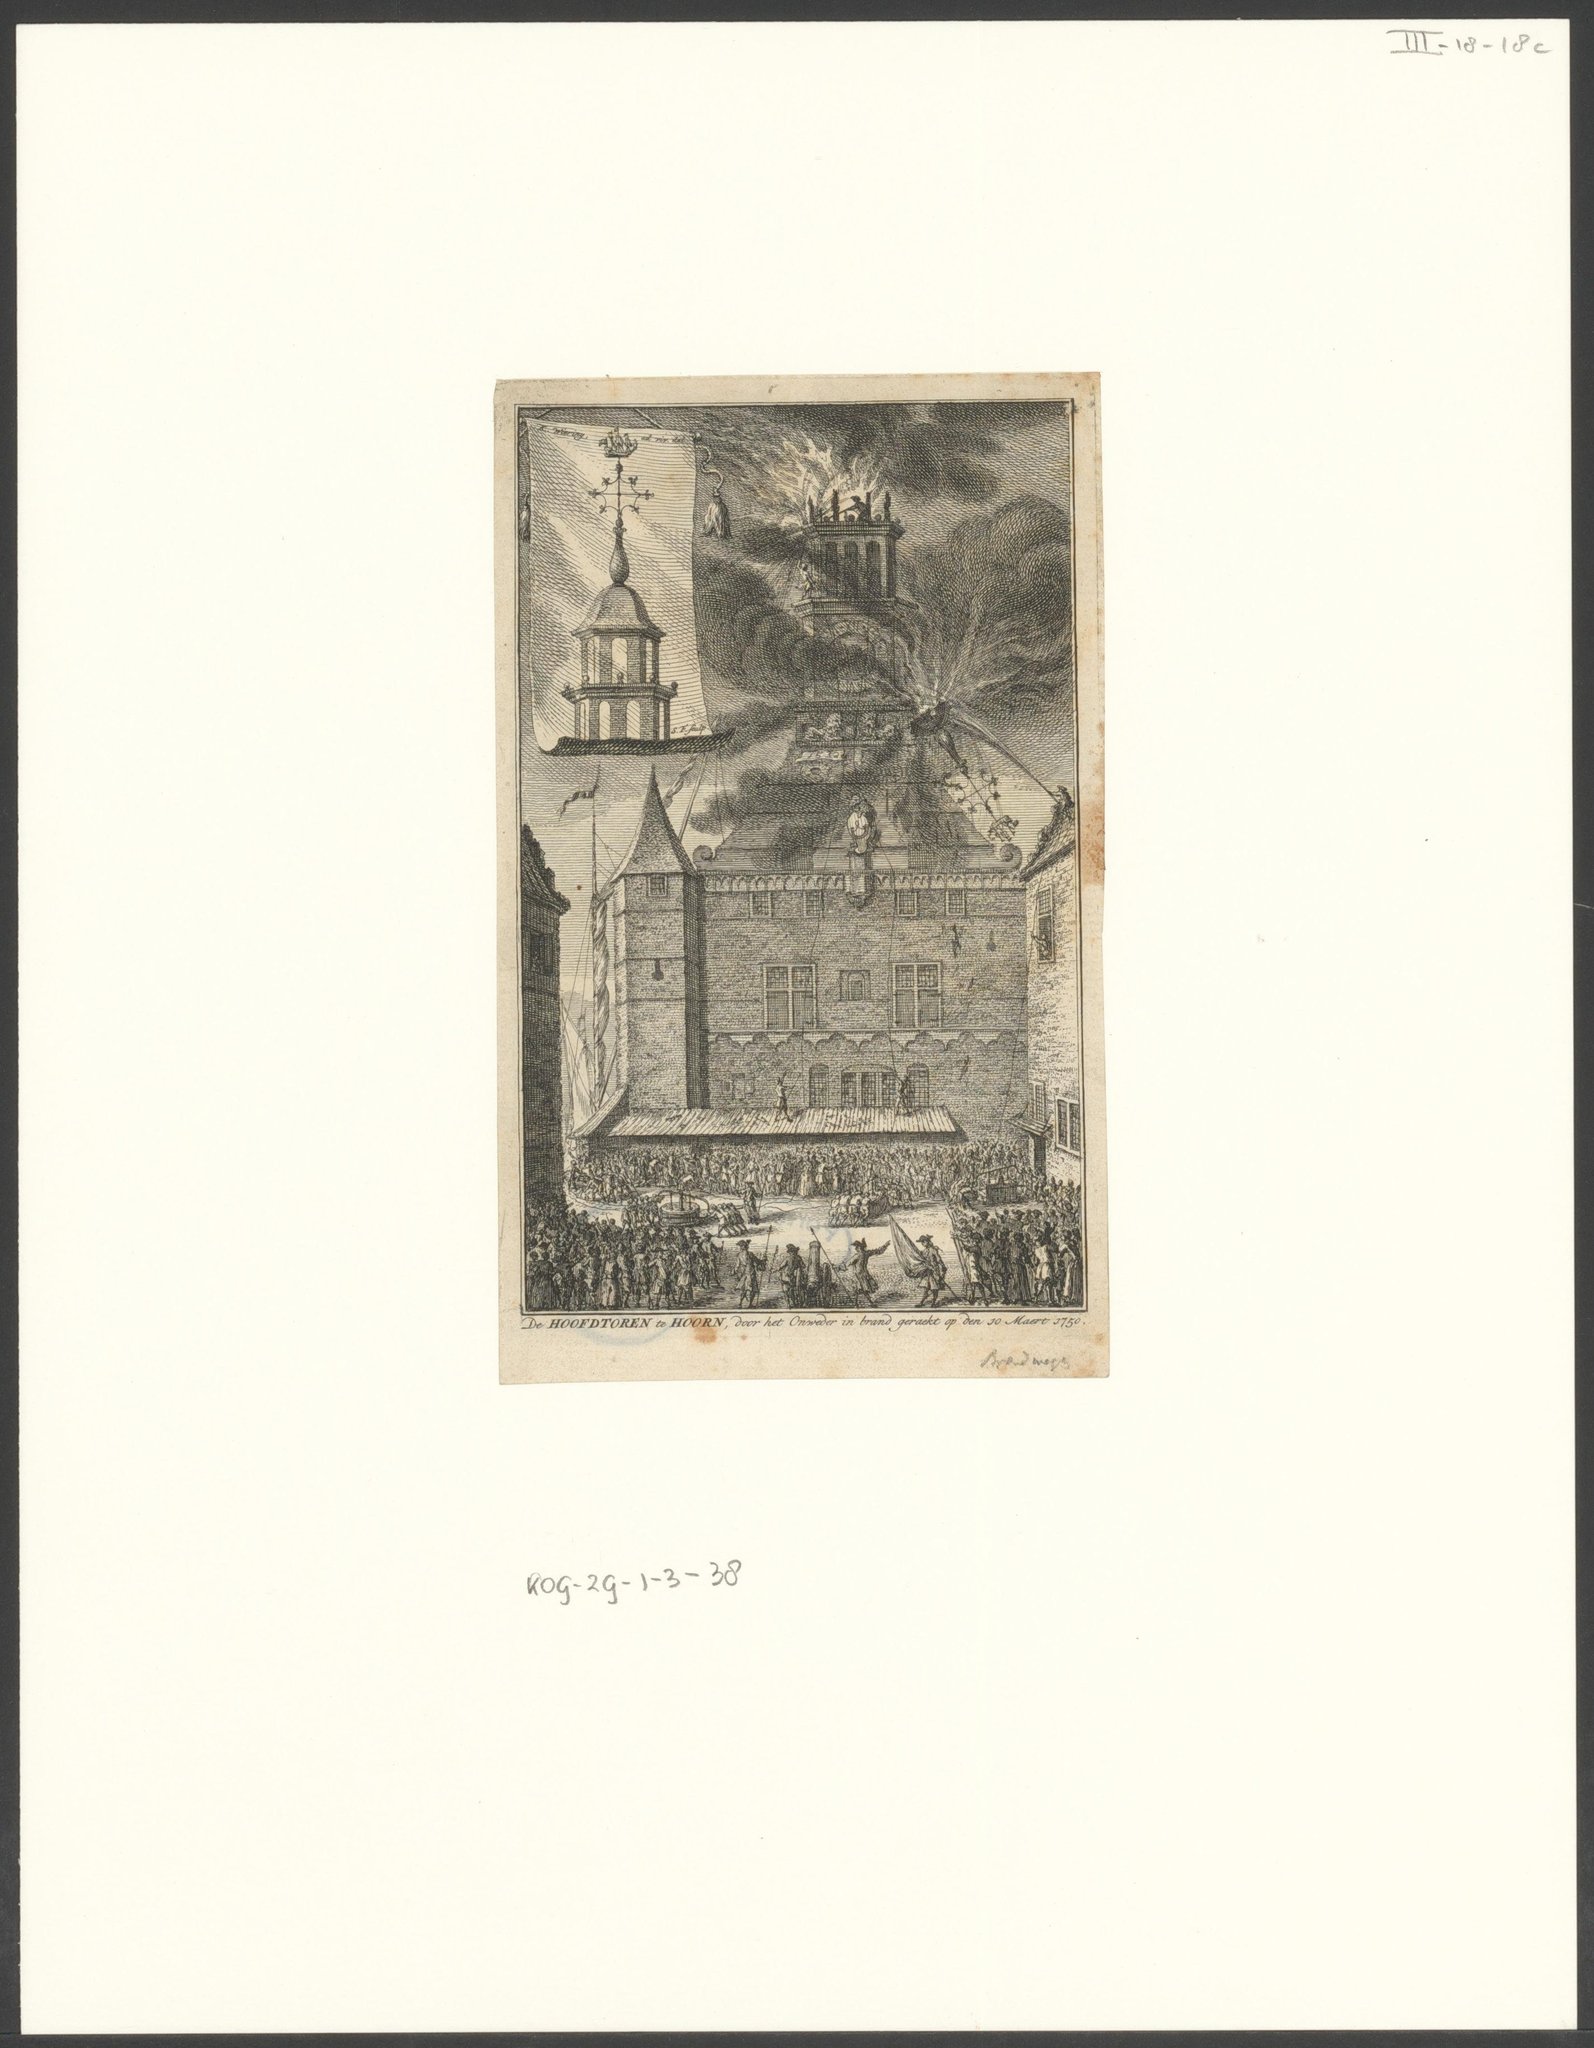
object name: print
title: Brand in de Hoofdtoren te Hoorn, 1750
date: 1750-1752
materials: paper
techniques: engraving, etching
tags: on fire, ablaze, spire (of tower on house or building), fire-fighting, tower (of house or building), fire-extinguishing equipment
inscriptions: collector's mark: Lugt 1641, stamp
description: Brand in de Hoofdtoren te Hoorn ontstaan door onweer, 10 maart 1750. Tijdens het blussen van de brand valt de spits van de toren naar beneden. Linksboven een inzet met de toestand van de spits vóór de brand. Onderwerpsrubrieken binnen de Atlas Zeden en Gewoonten: Regeering, Brandwezen.